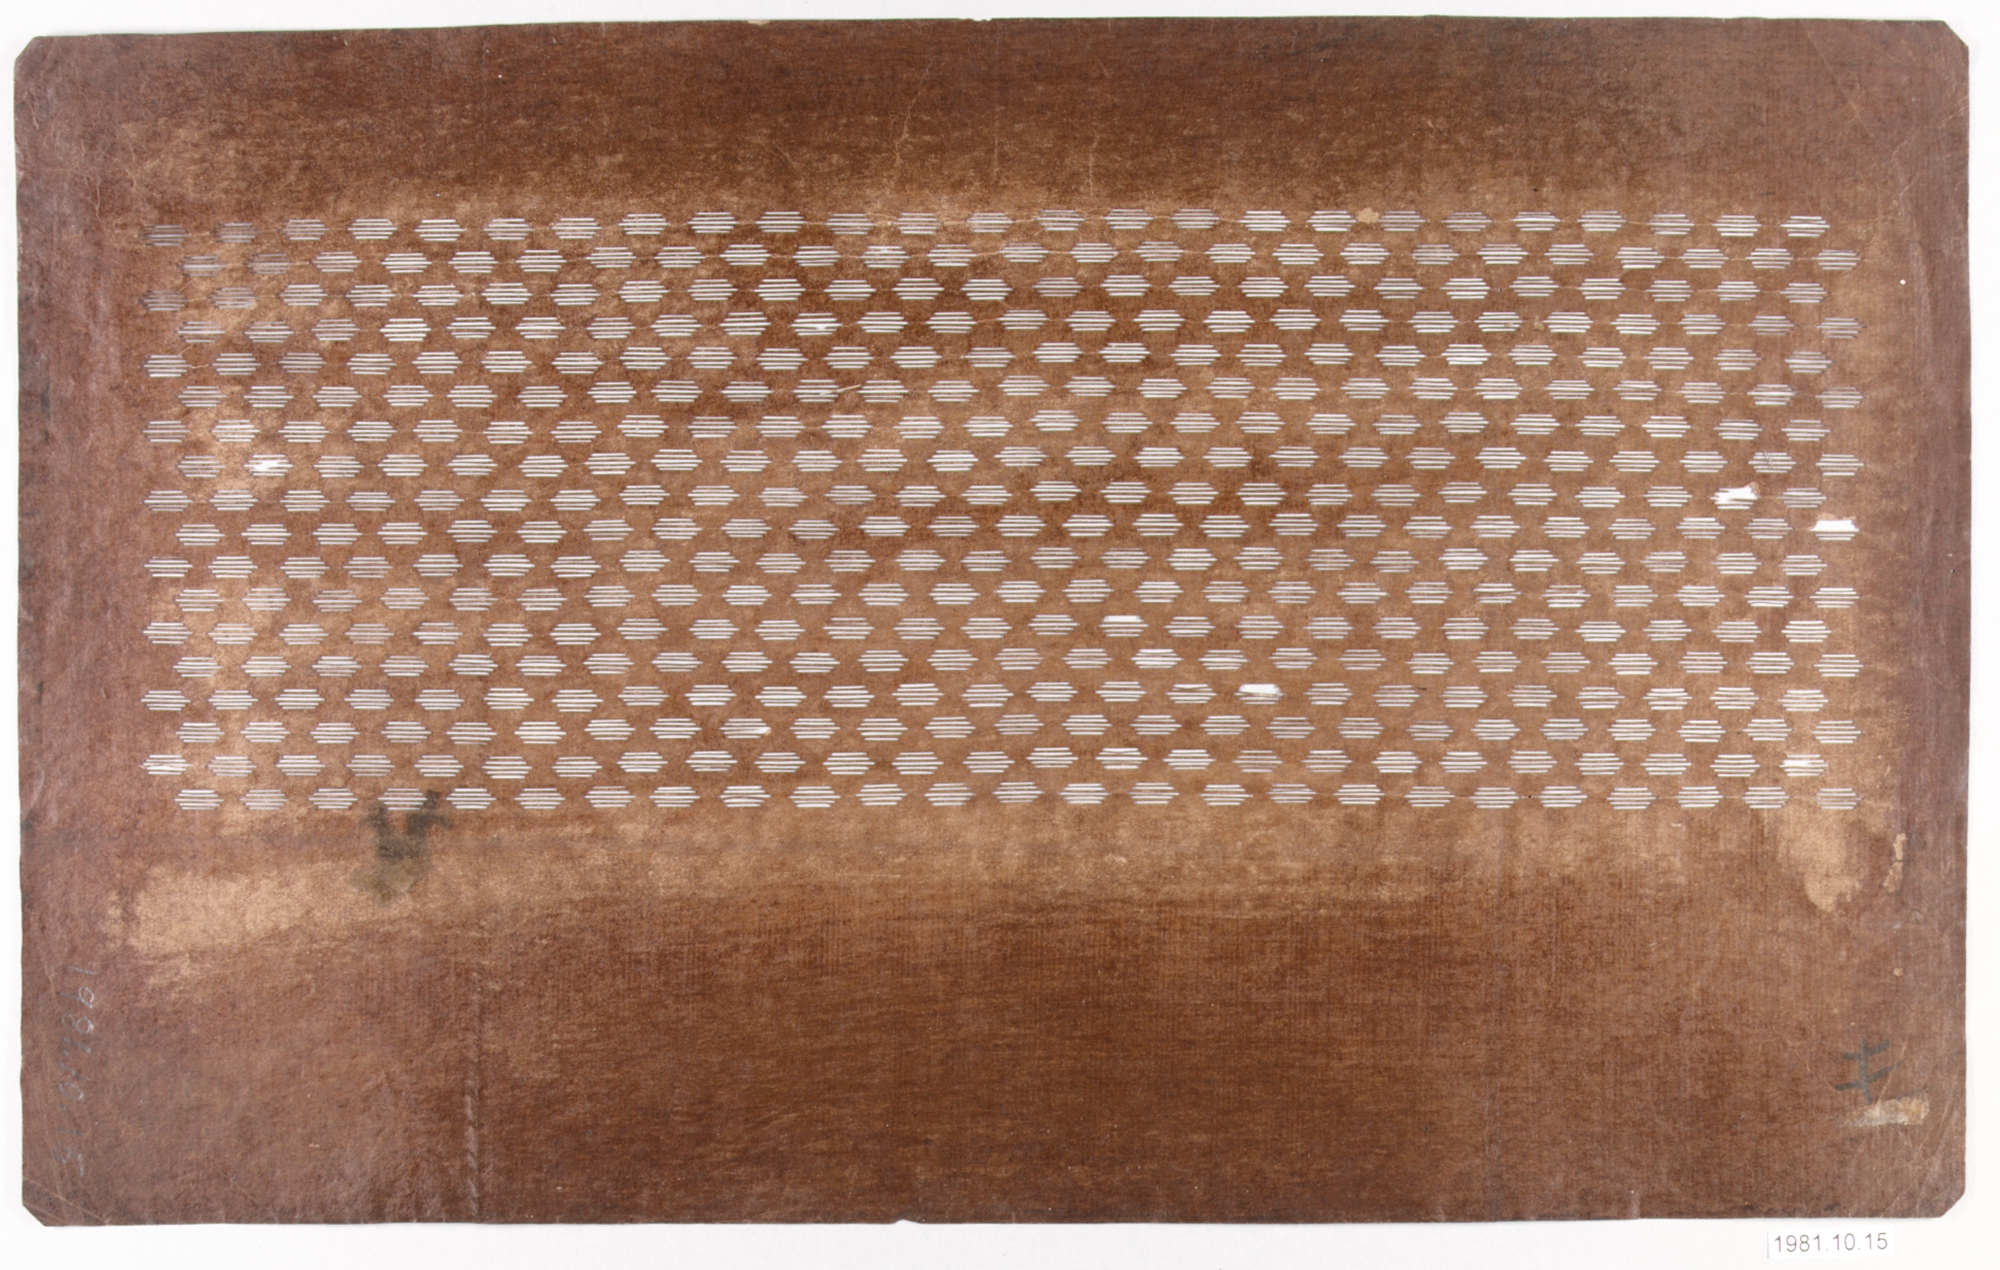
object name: stencil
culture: japanese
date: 1801-1900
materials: paper